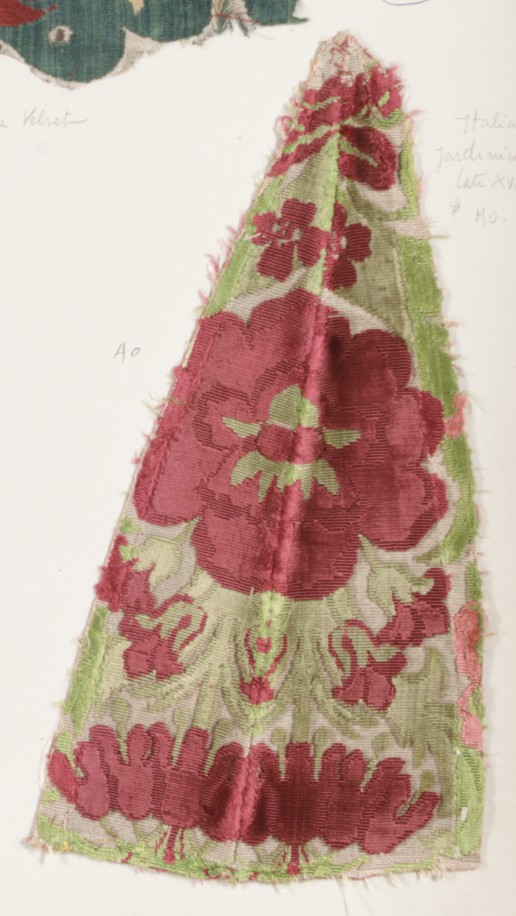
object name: fragment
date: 1667-1700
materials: metal thread, silk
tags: flowers